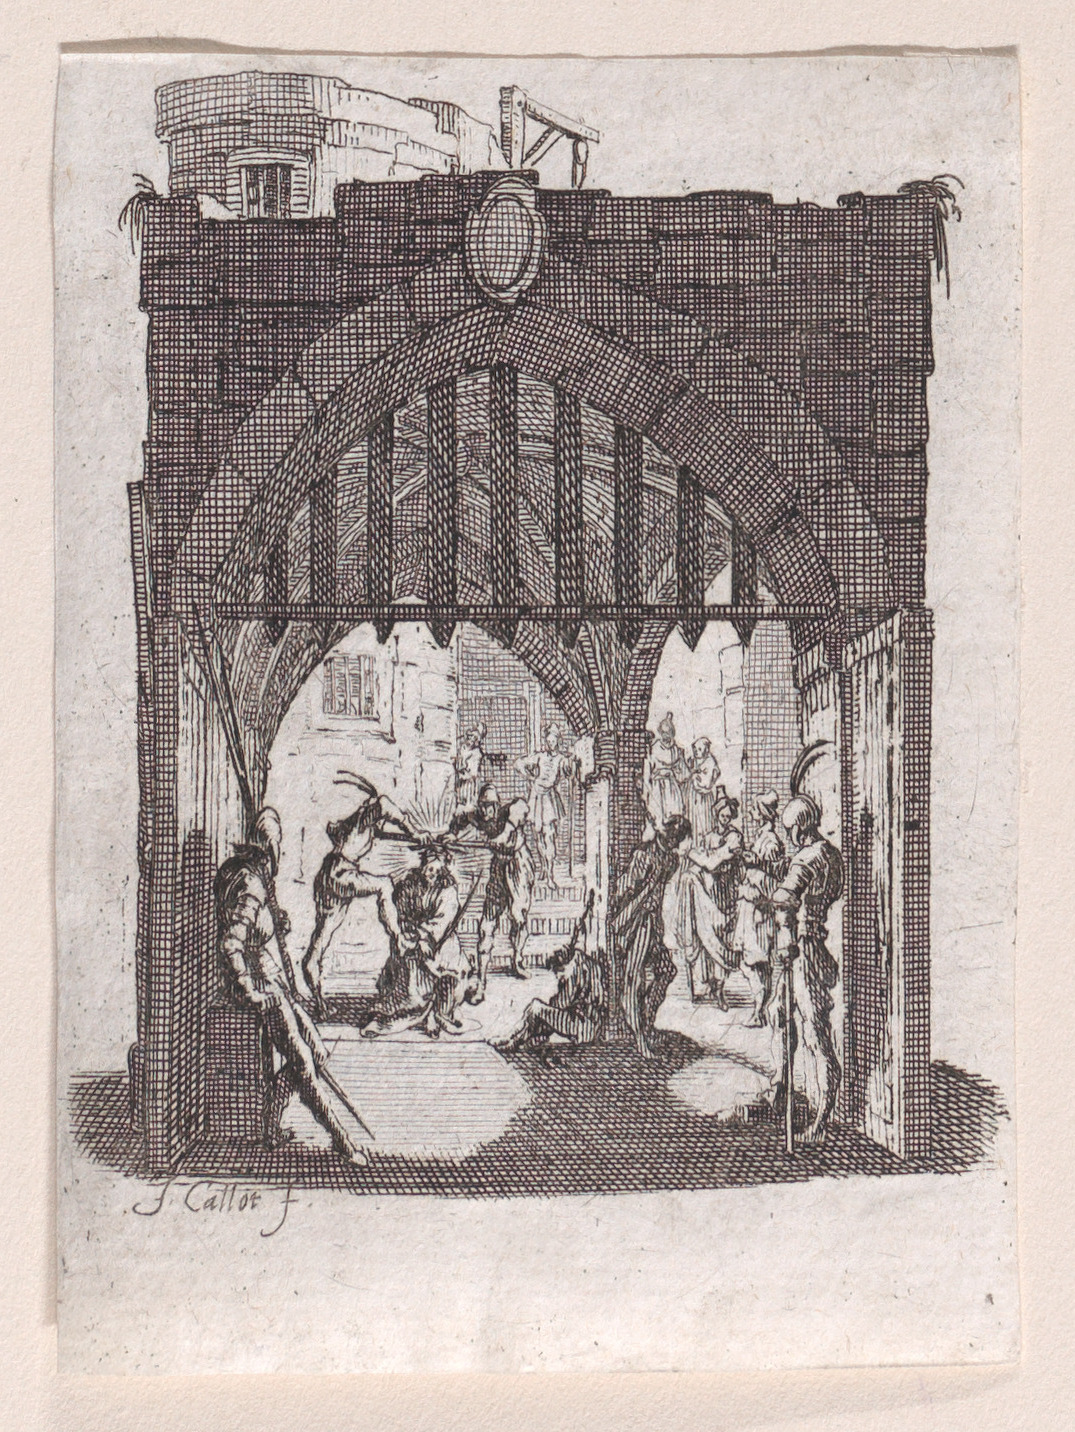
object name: print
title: Le Couronnement d'Épines (The Crowning with Thornes), from "La Petite Passion" (The Little Passion)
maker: jacques callot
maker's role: artist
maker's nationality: french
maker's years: 1592-1635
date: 1624-1625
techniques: etching